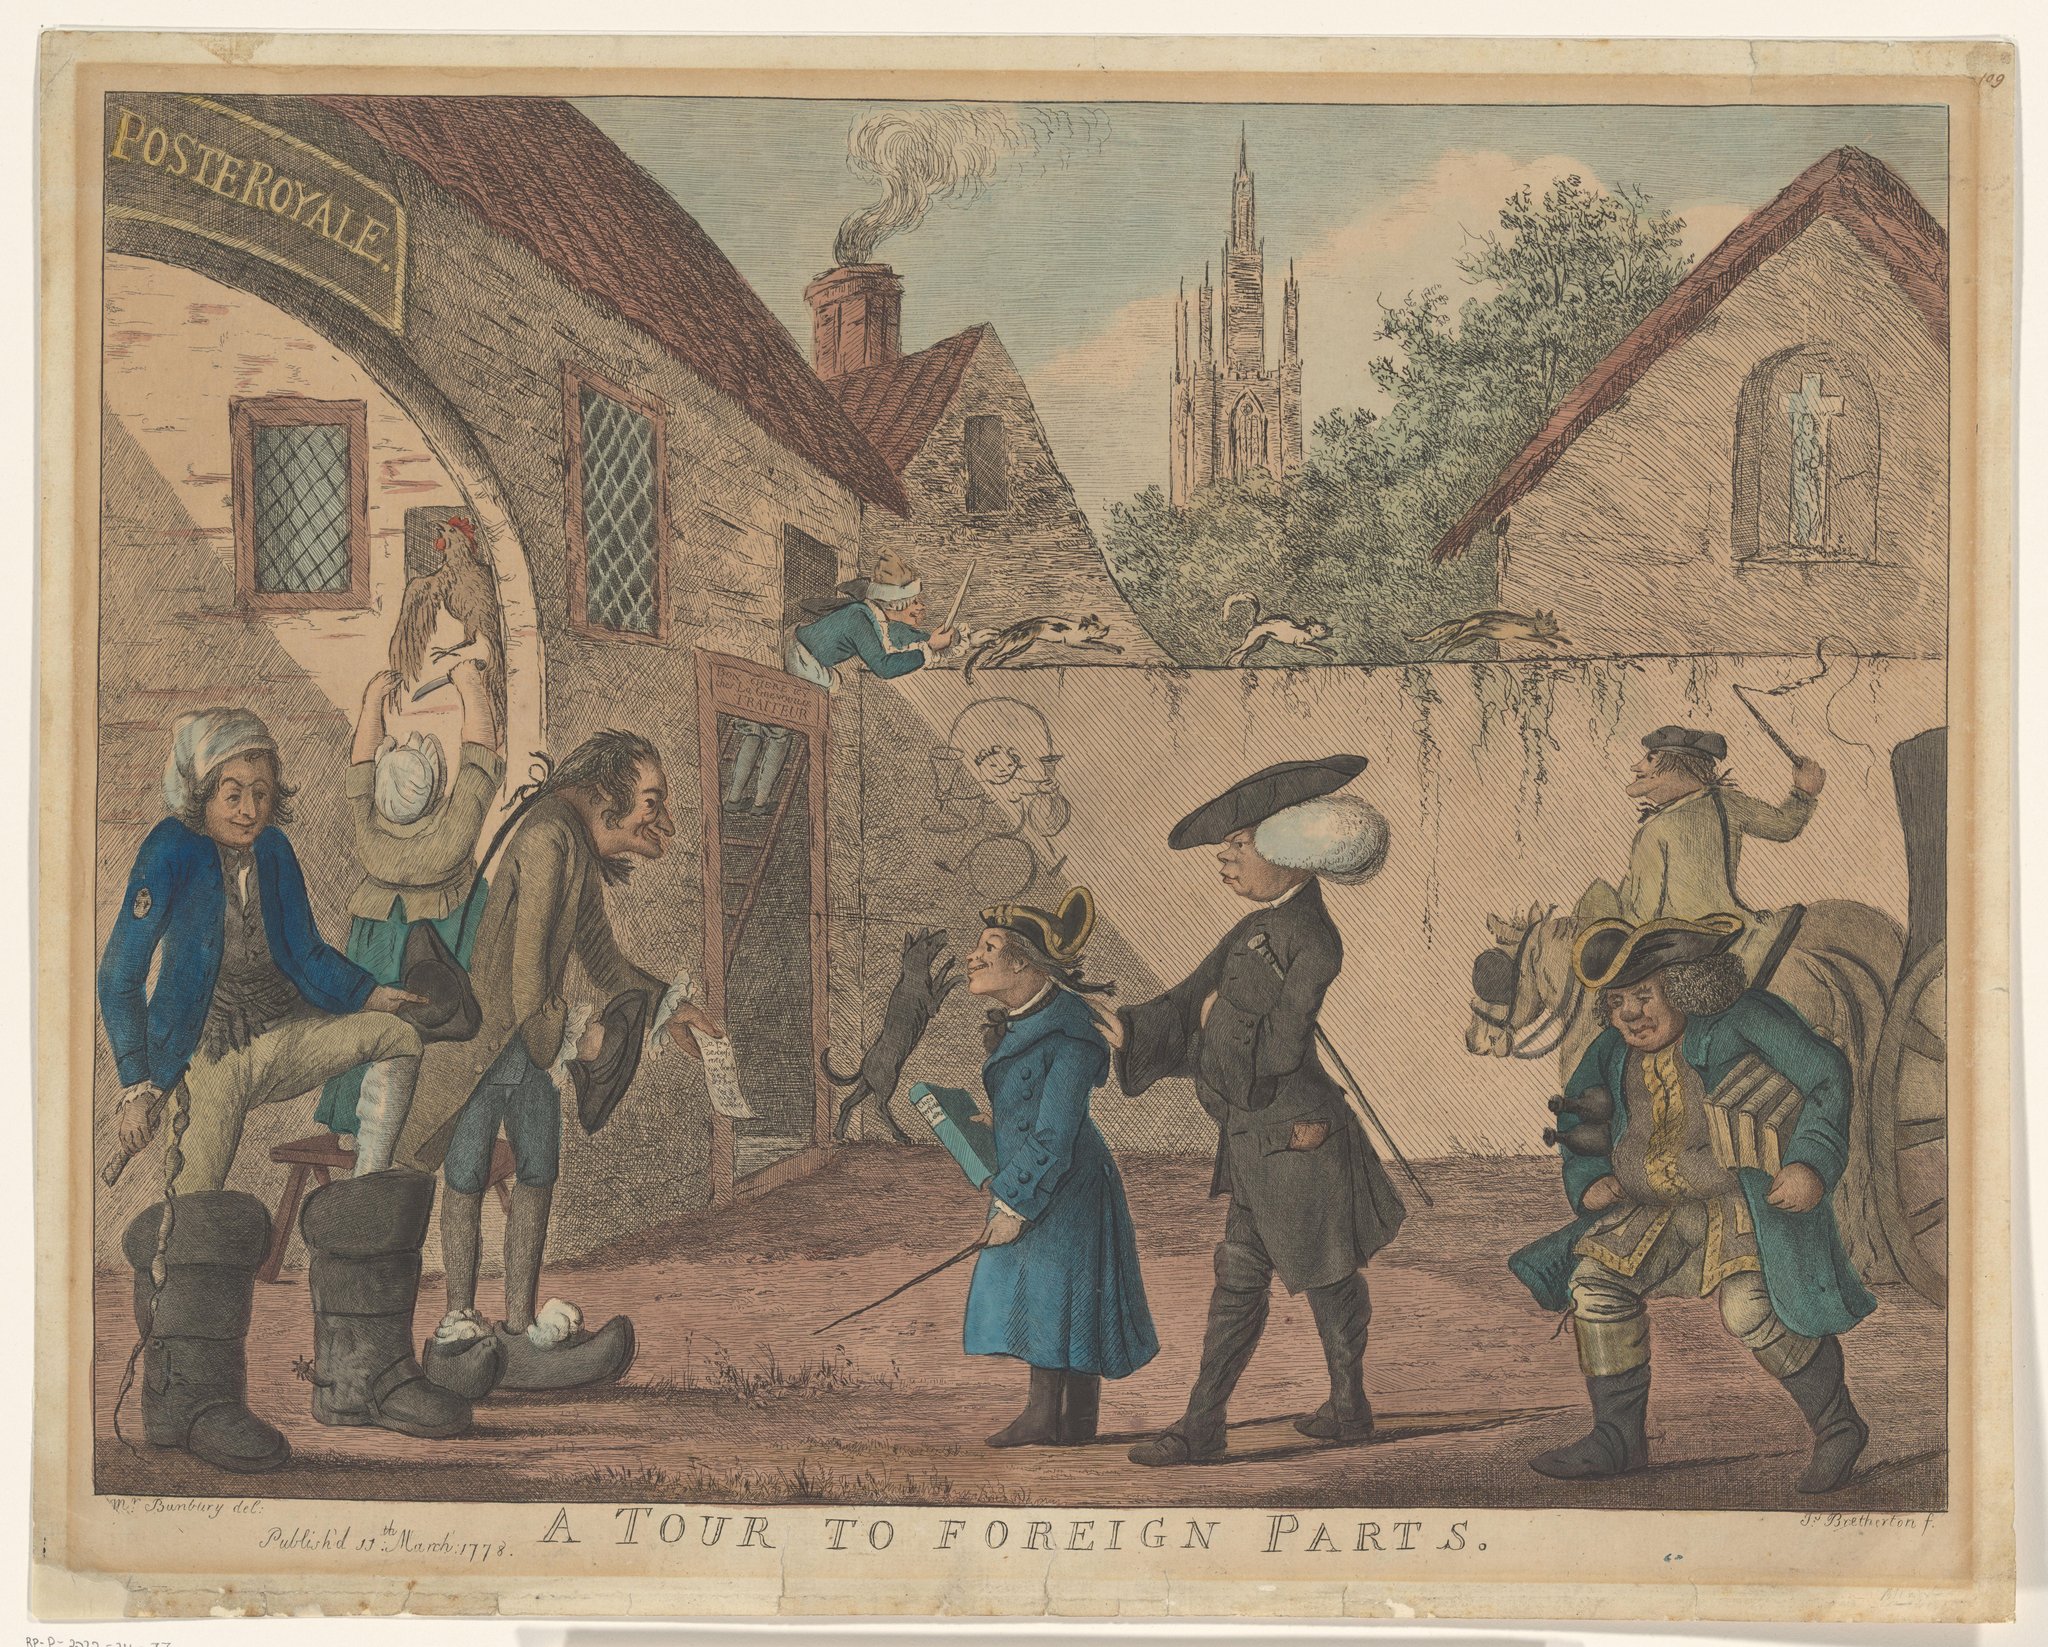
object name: cartoon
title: Grand tour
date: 1778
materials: paper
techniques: etching, hand coloring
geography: london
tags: caricatures (human types), stage (~ mail-coach), wooden shoes, clogs, europeans: french (+ caricatured), europeans: english (+ caricatured), grand tour, boots, hotel, hostelry, inn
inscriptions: collector's mark: Lugt 2228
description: Satire op Grand Tourists: scène buiten een herberg in Frankrijk, met een bord waarop staat "Poste Royale", waar een jonge Engelse heer met een exemplaar van "[Lord] Chesterfield's Letters" aankomt met zijn mentor.